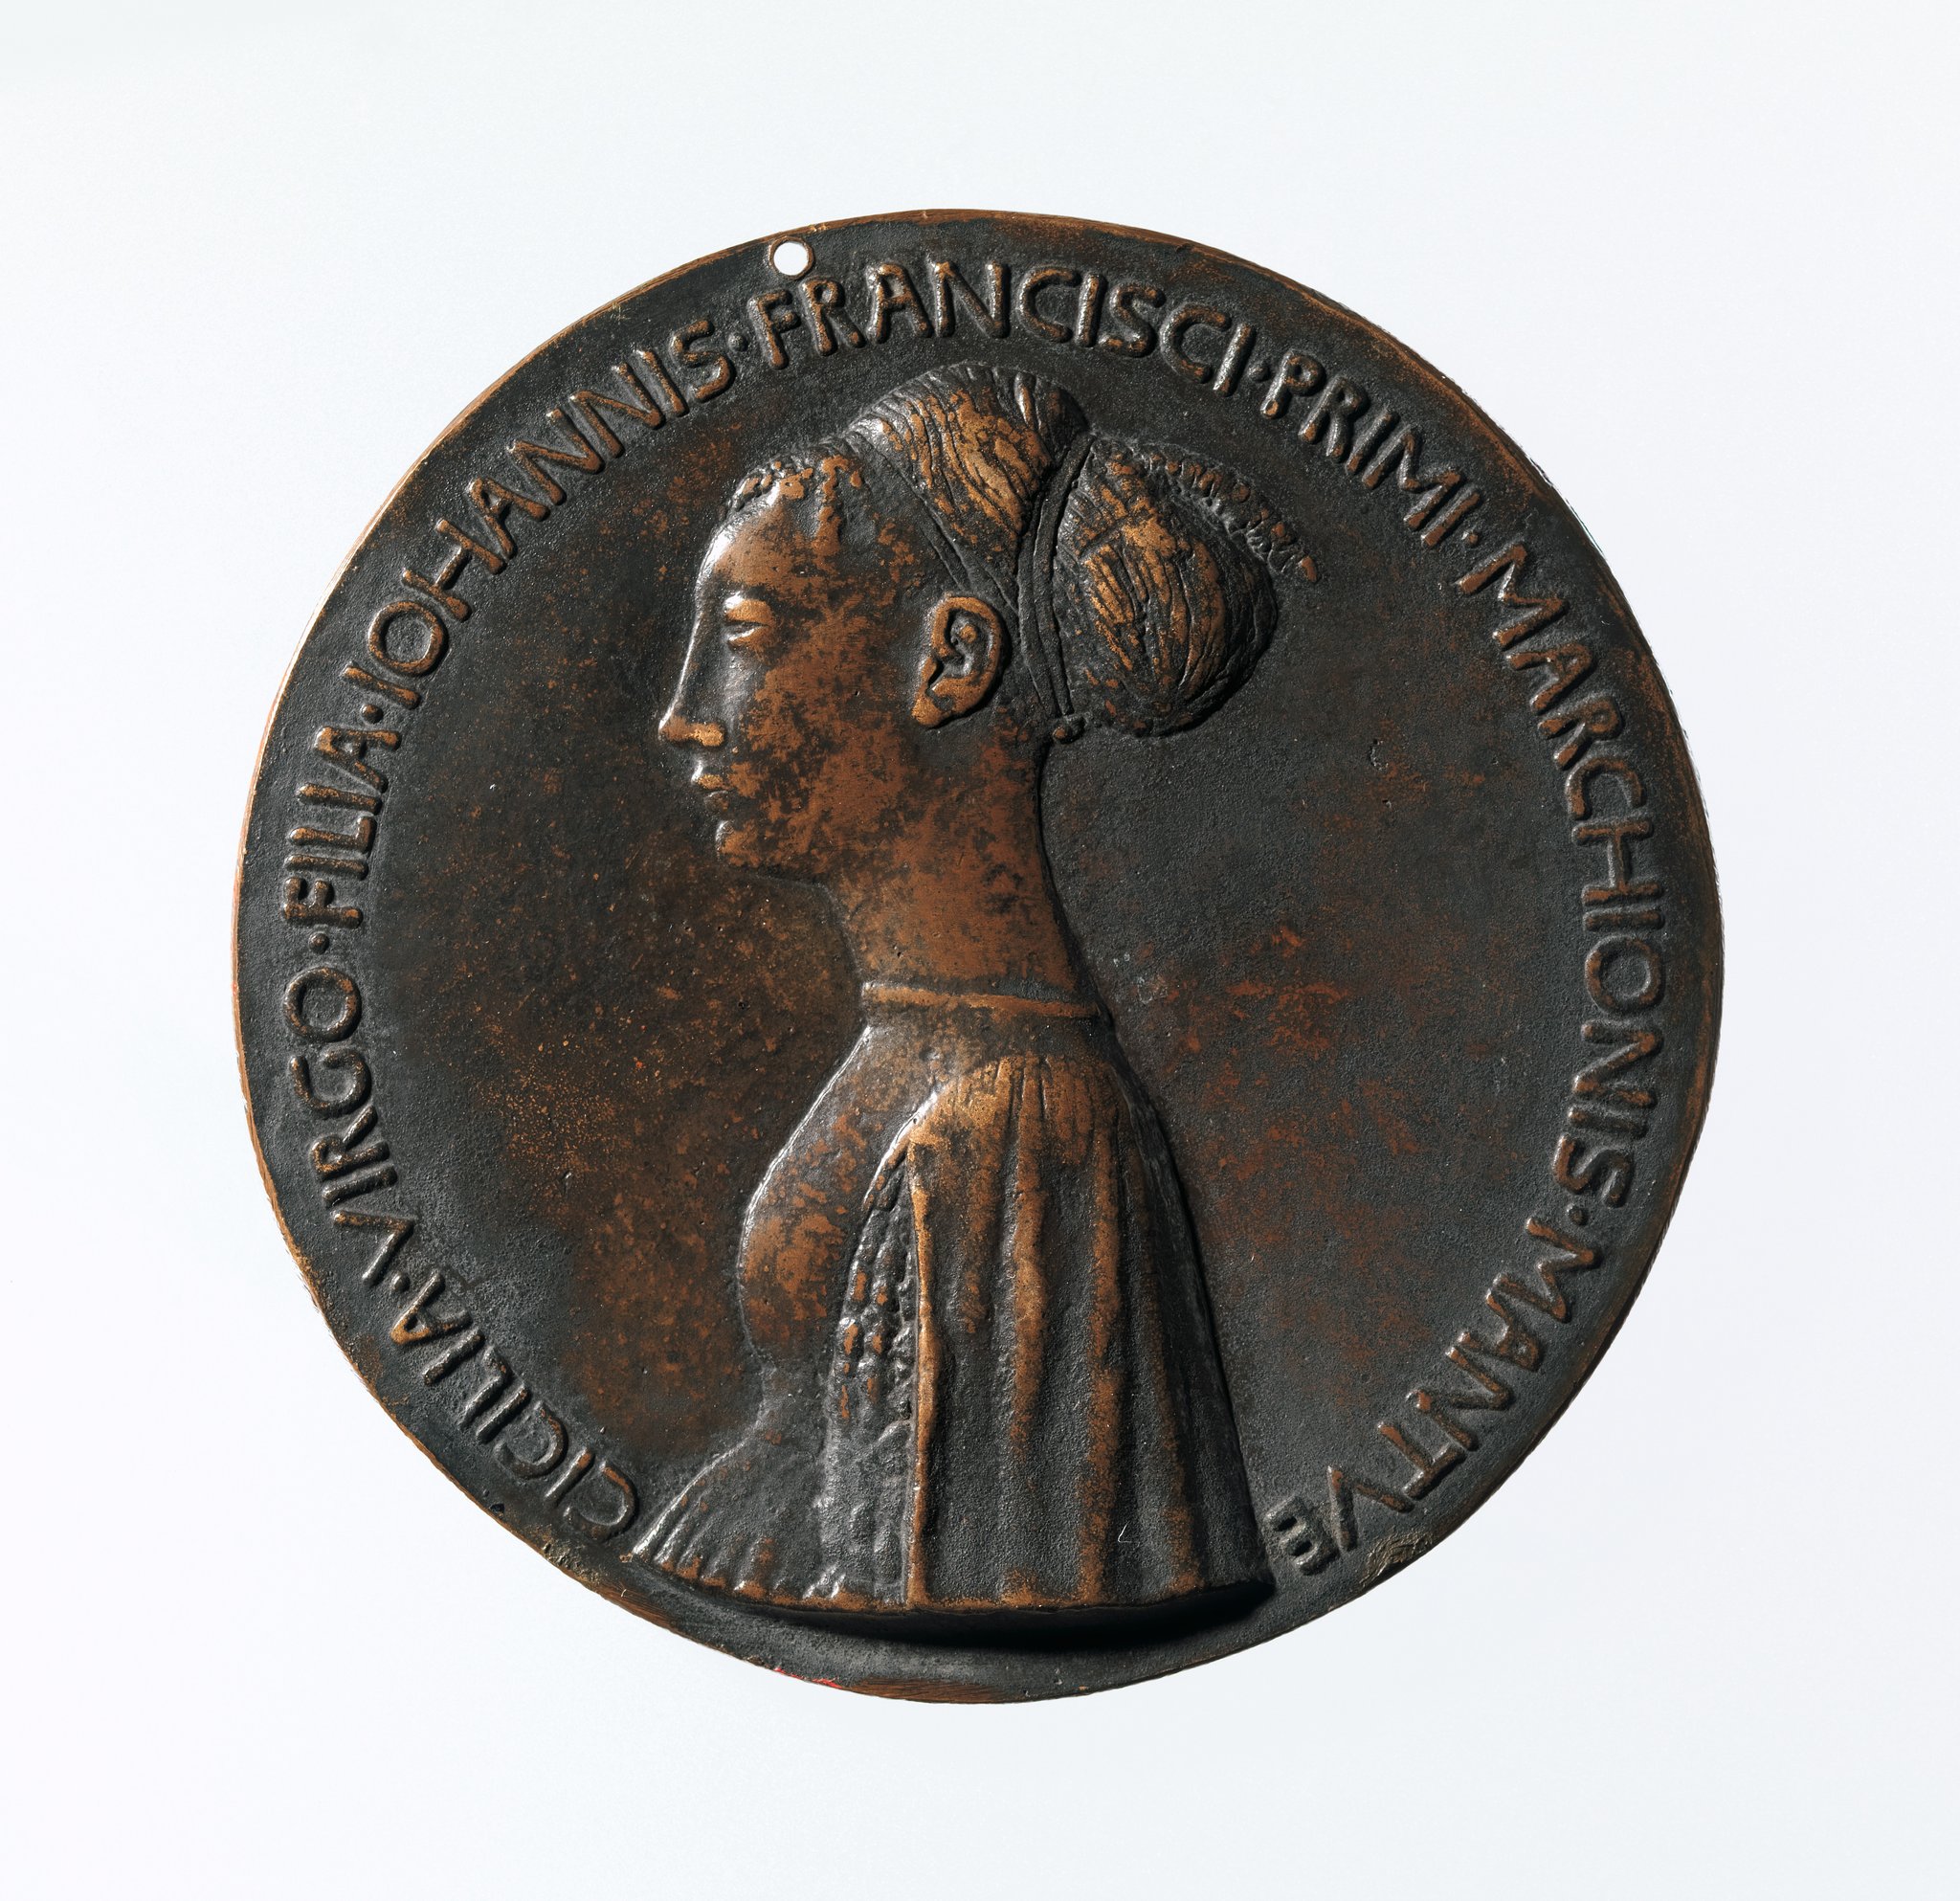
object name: medal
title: Portrait medal of Cecilia Gonzaga (obverse); Innocence and a Unicorn in a Moonlit Landscape (reverse)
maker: pisanello (antonio pisano)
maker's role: artist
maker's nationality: italian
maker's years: 1395-1455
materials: bronze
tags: profiles,women